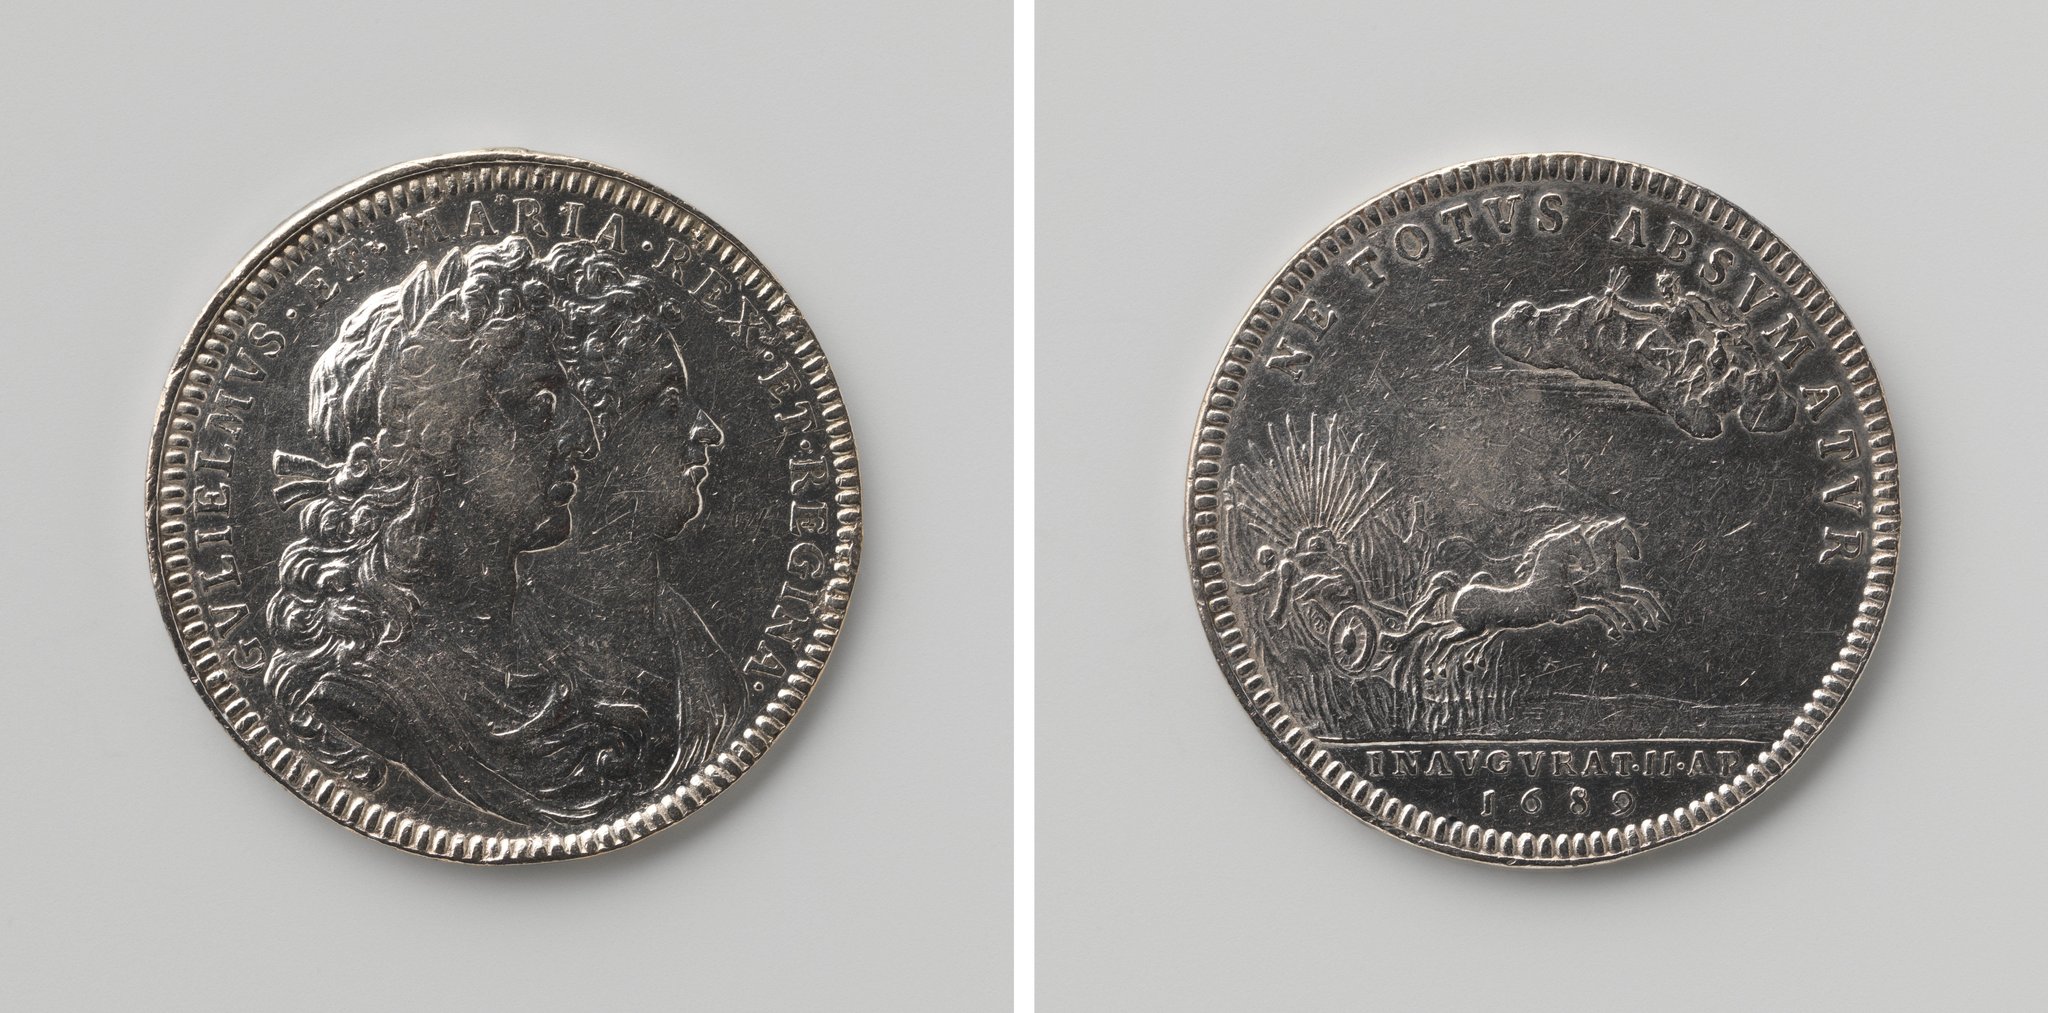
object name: strooipenning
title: Kroning van Willem III en Maria II Stuart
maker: jean roëttiers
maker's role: medailleur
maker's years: 1631-1703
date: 1689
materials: silver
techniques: striking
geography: london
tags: the hague, william iii (prince of orange and king of england, scotland, and ireland), maria ii stuart (koningin van engeland, schotland en ierland)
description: Zilveren penning. Voorzijde: borststuk man met lauwerkrans en vrouw binnen omschrift. Keerzijde: Phaeton, door bliksem van Jupitter getroffen stort van zonnewagen binnen omschrift; afsnede: opschrift